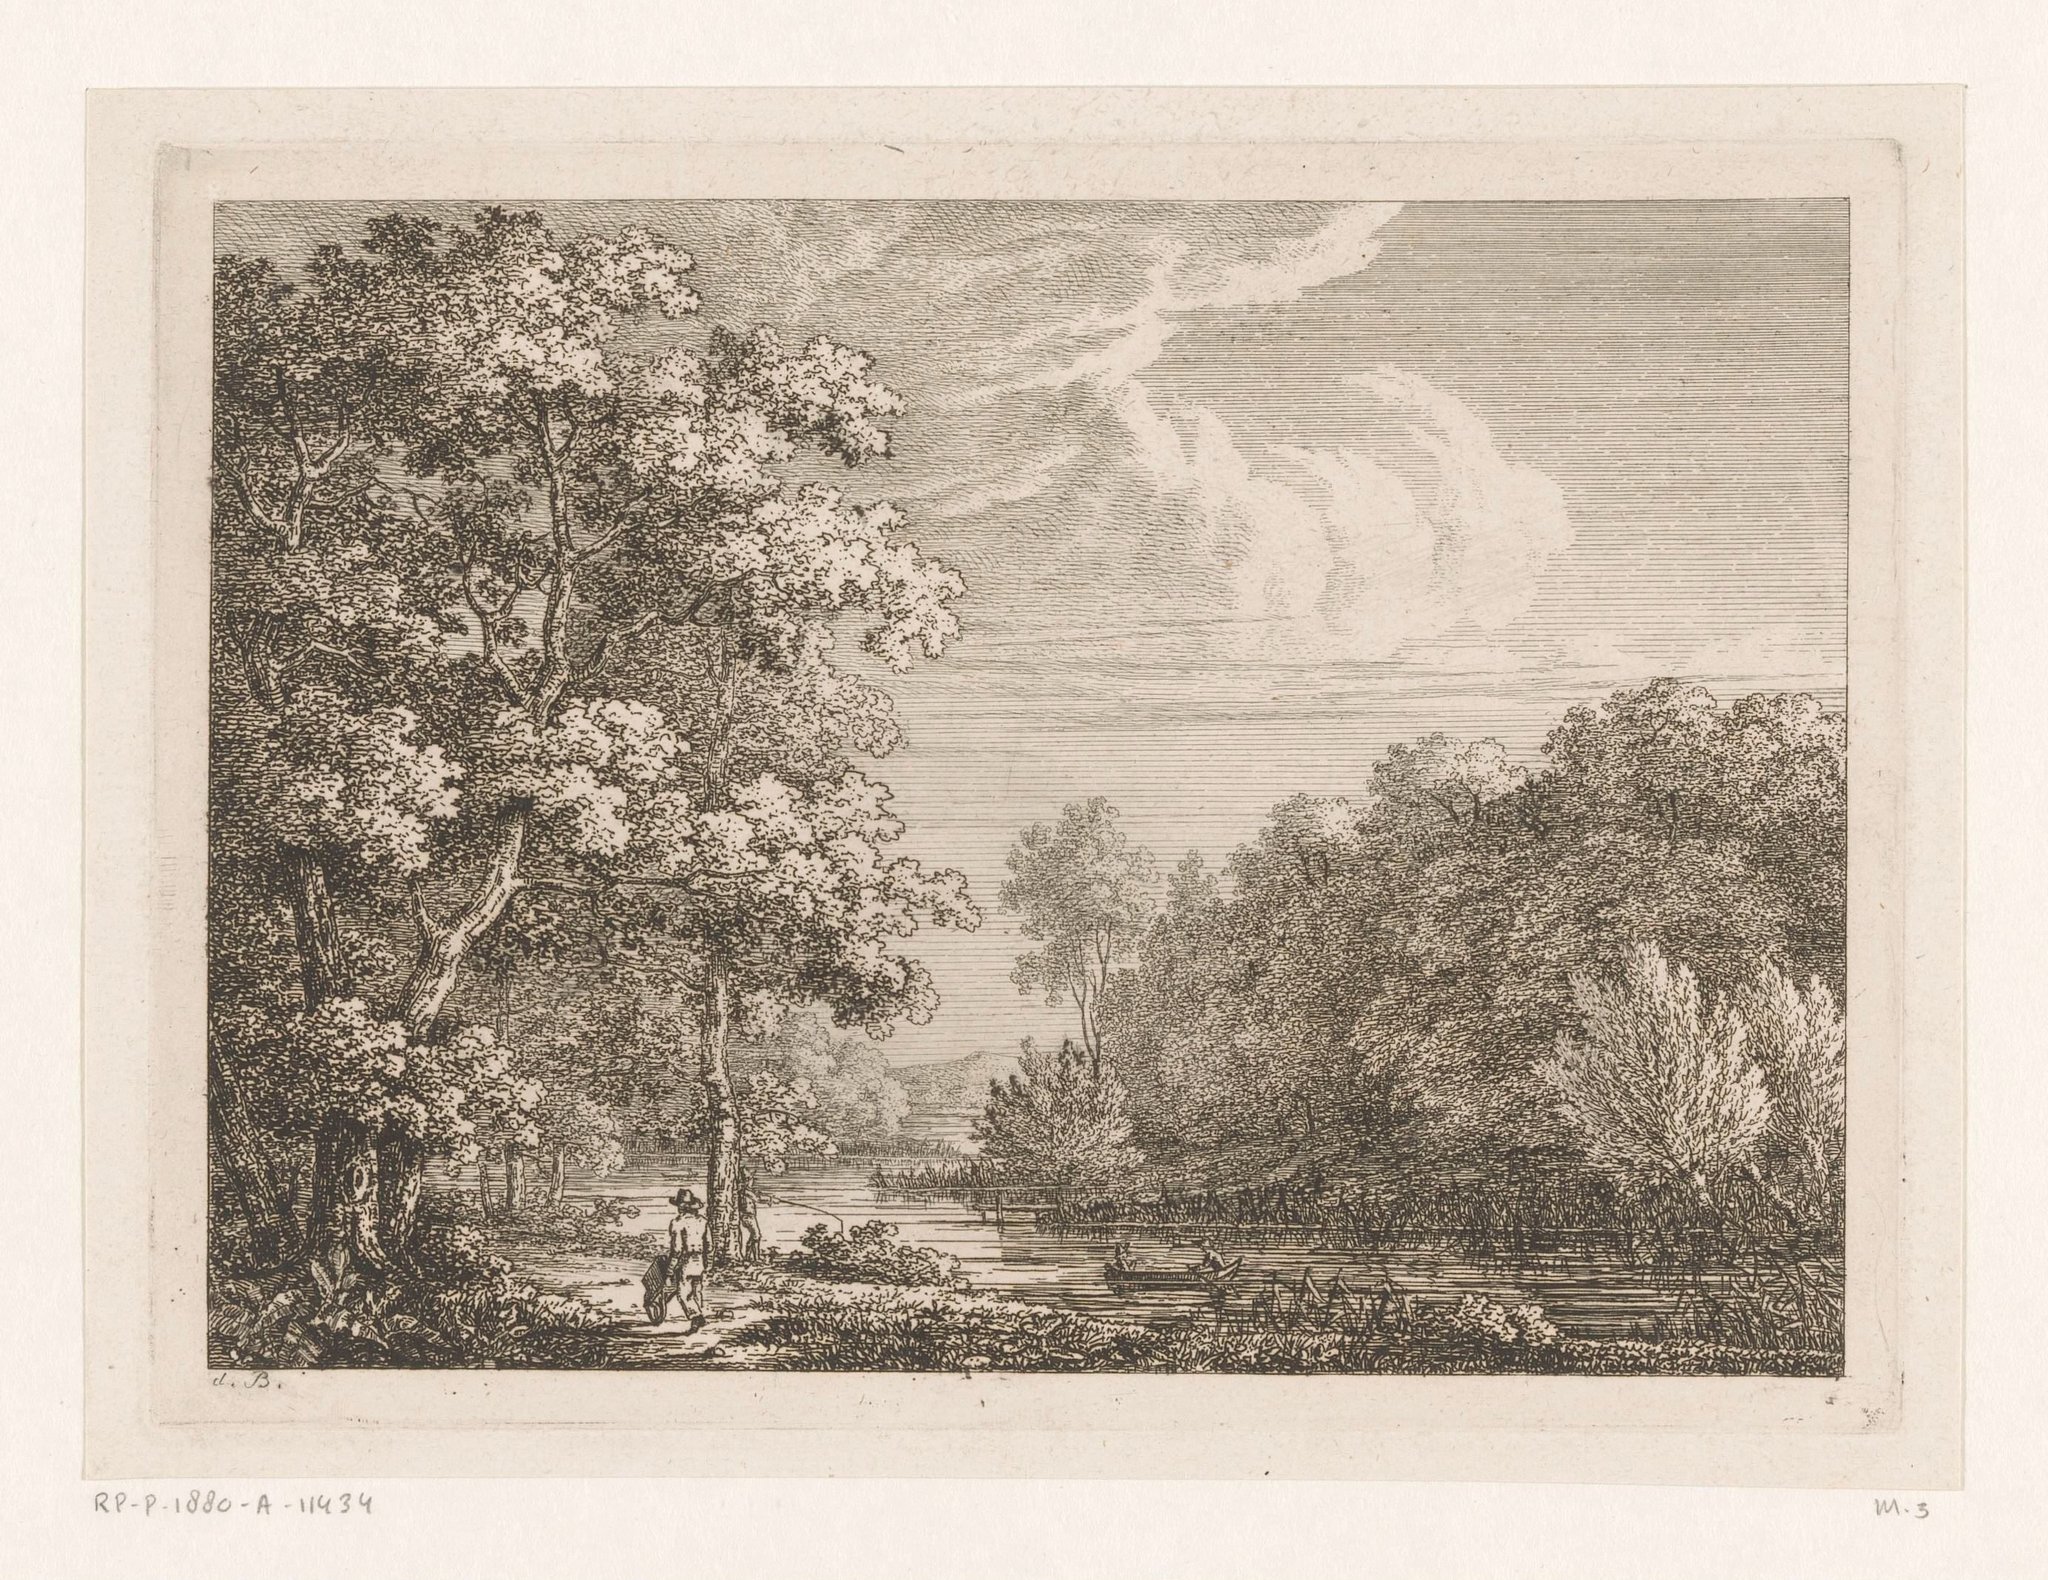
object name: print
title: Boslandschap met een rivier, een man met een kruiwagen op de voorgrond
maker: andré paul de beurs-stiermans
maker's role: print maker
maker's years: 1802-1832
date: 1812-1832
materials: paper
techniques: etching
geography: hamburg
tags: landscapes, rowing-boat, canoe, etc., wheelbarrow, angling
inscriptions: collector's mark: Lugt 2228